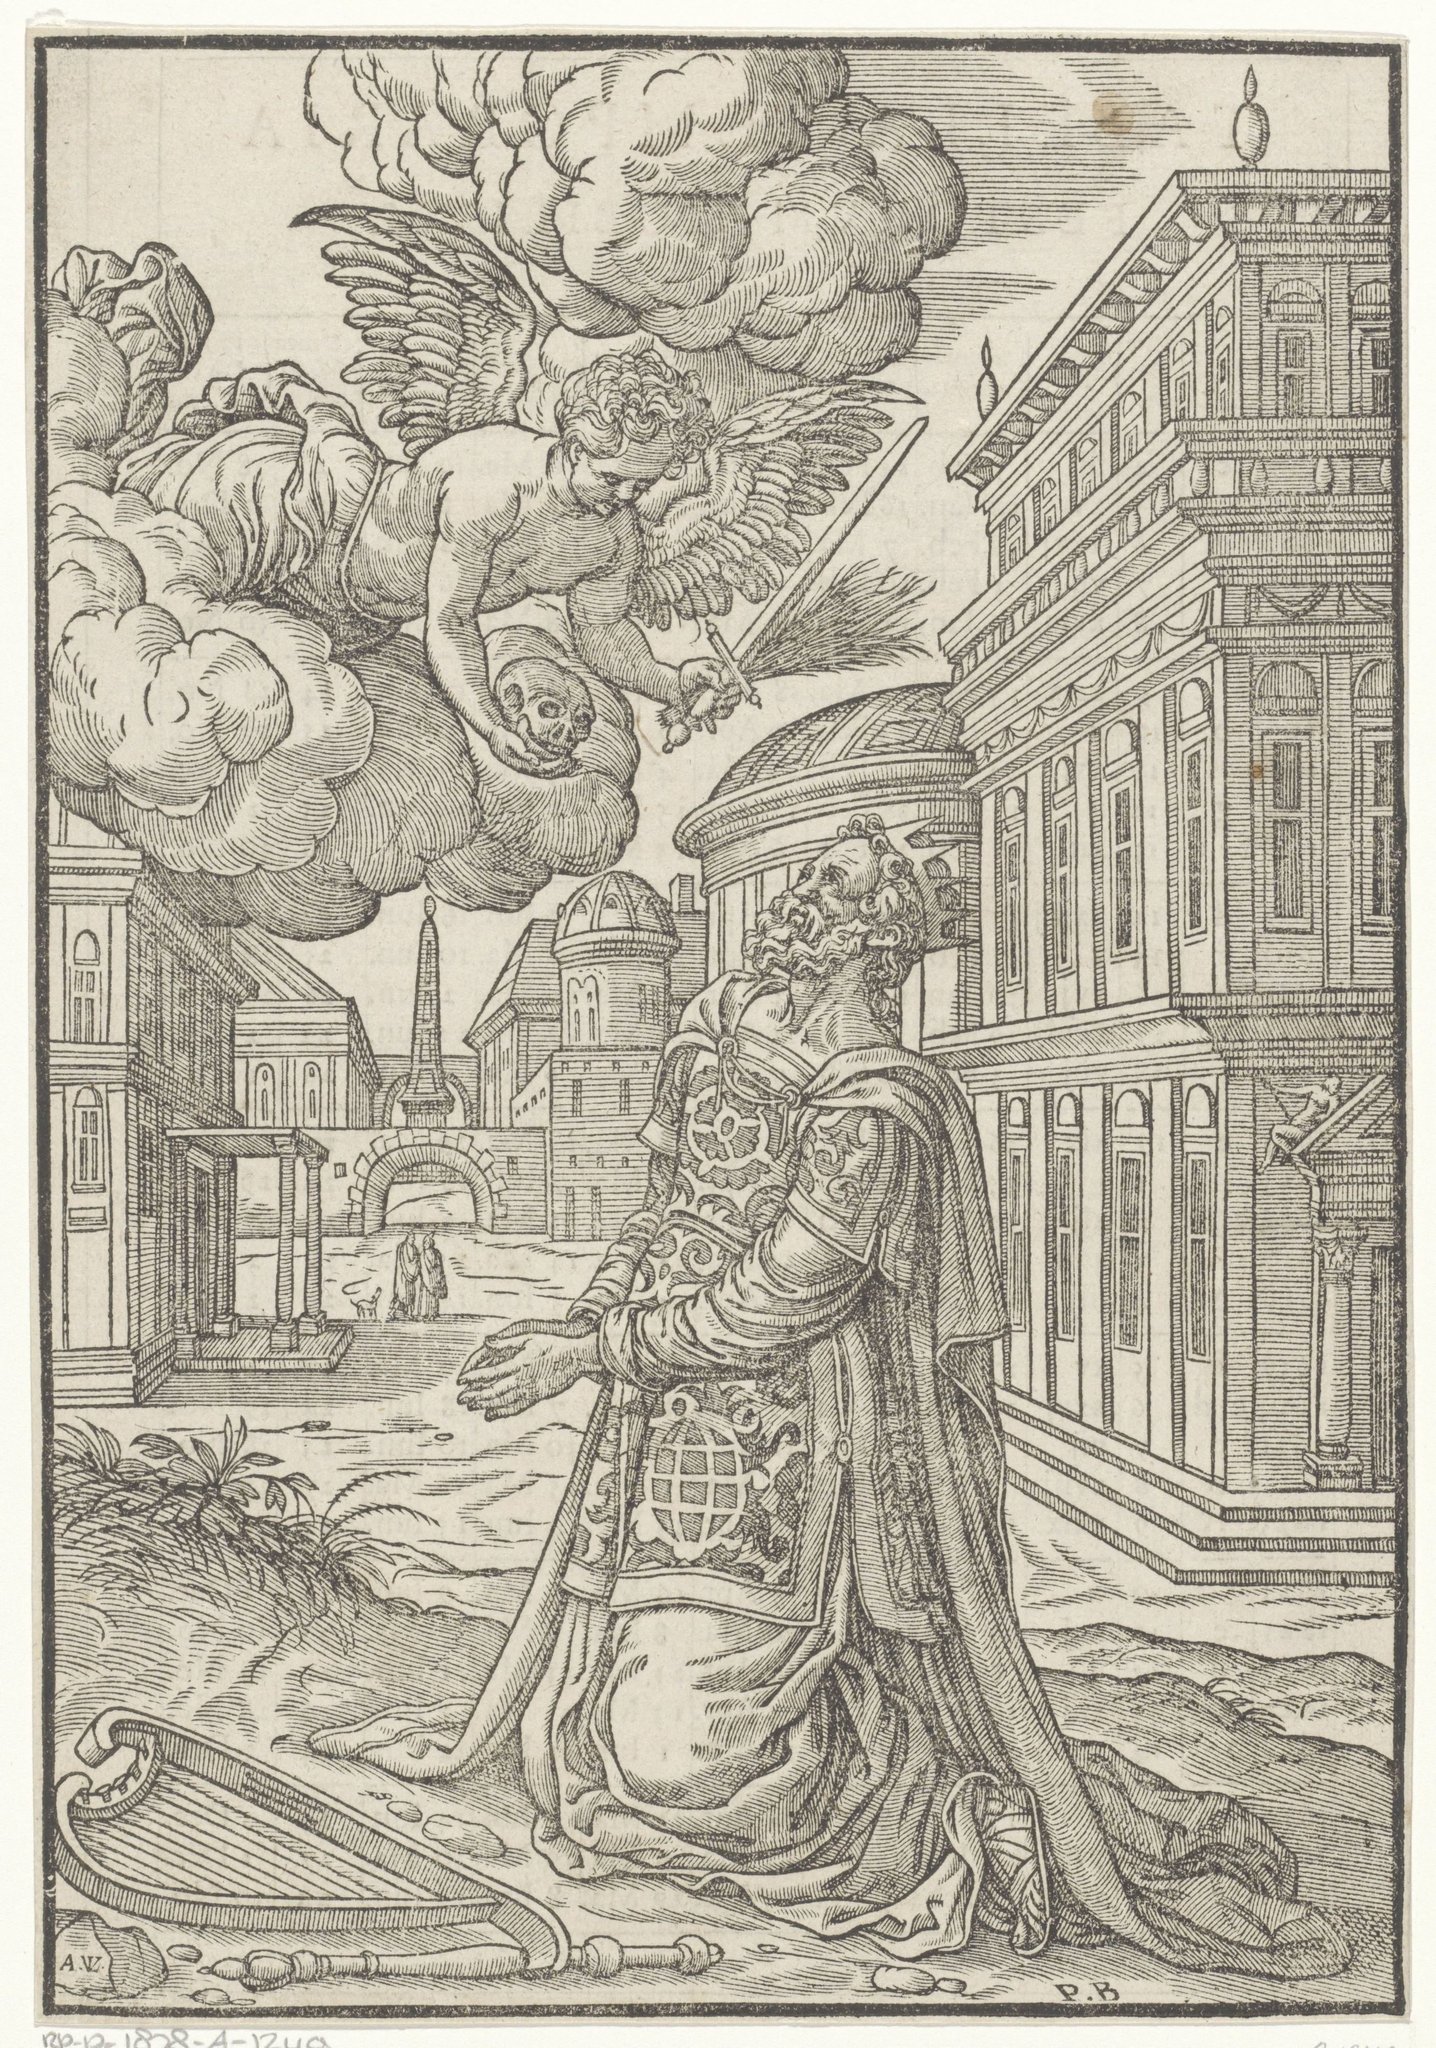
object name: book illustration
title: Knielende David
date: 1571-1632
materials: paper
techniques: letterpress printing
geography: antwerp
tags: david sacrificing (in general)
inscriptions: collector's mark: Lugt 2228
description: Prent uit: Missale Romanorum. Antwerpen: Christoffel Plantijn, 1571-1632.